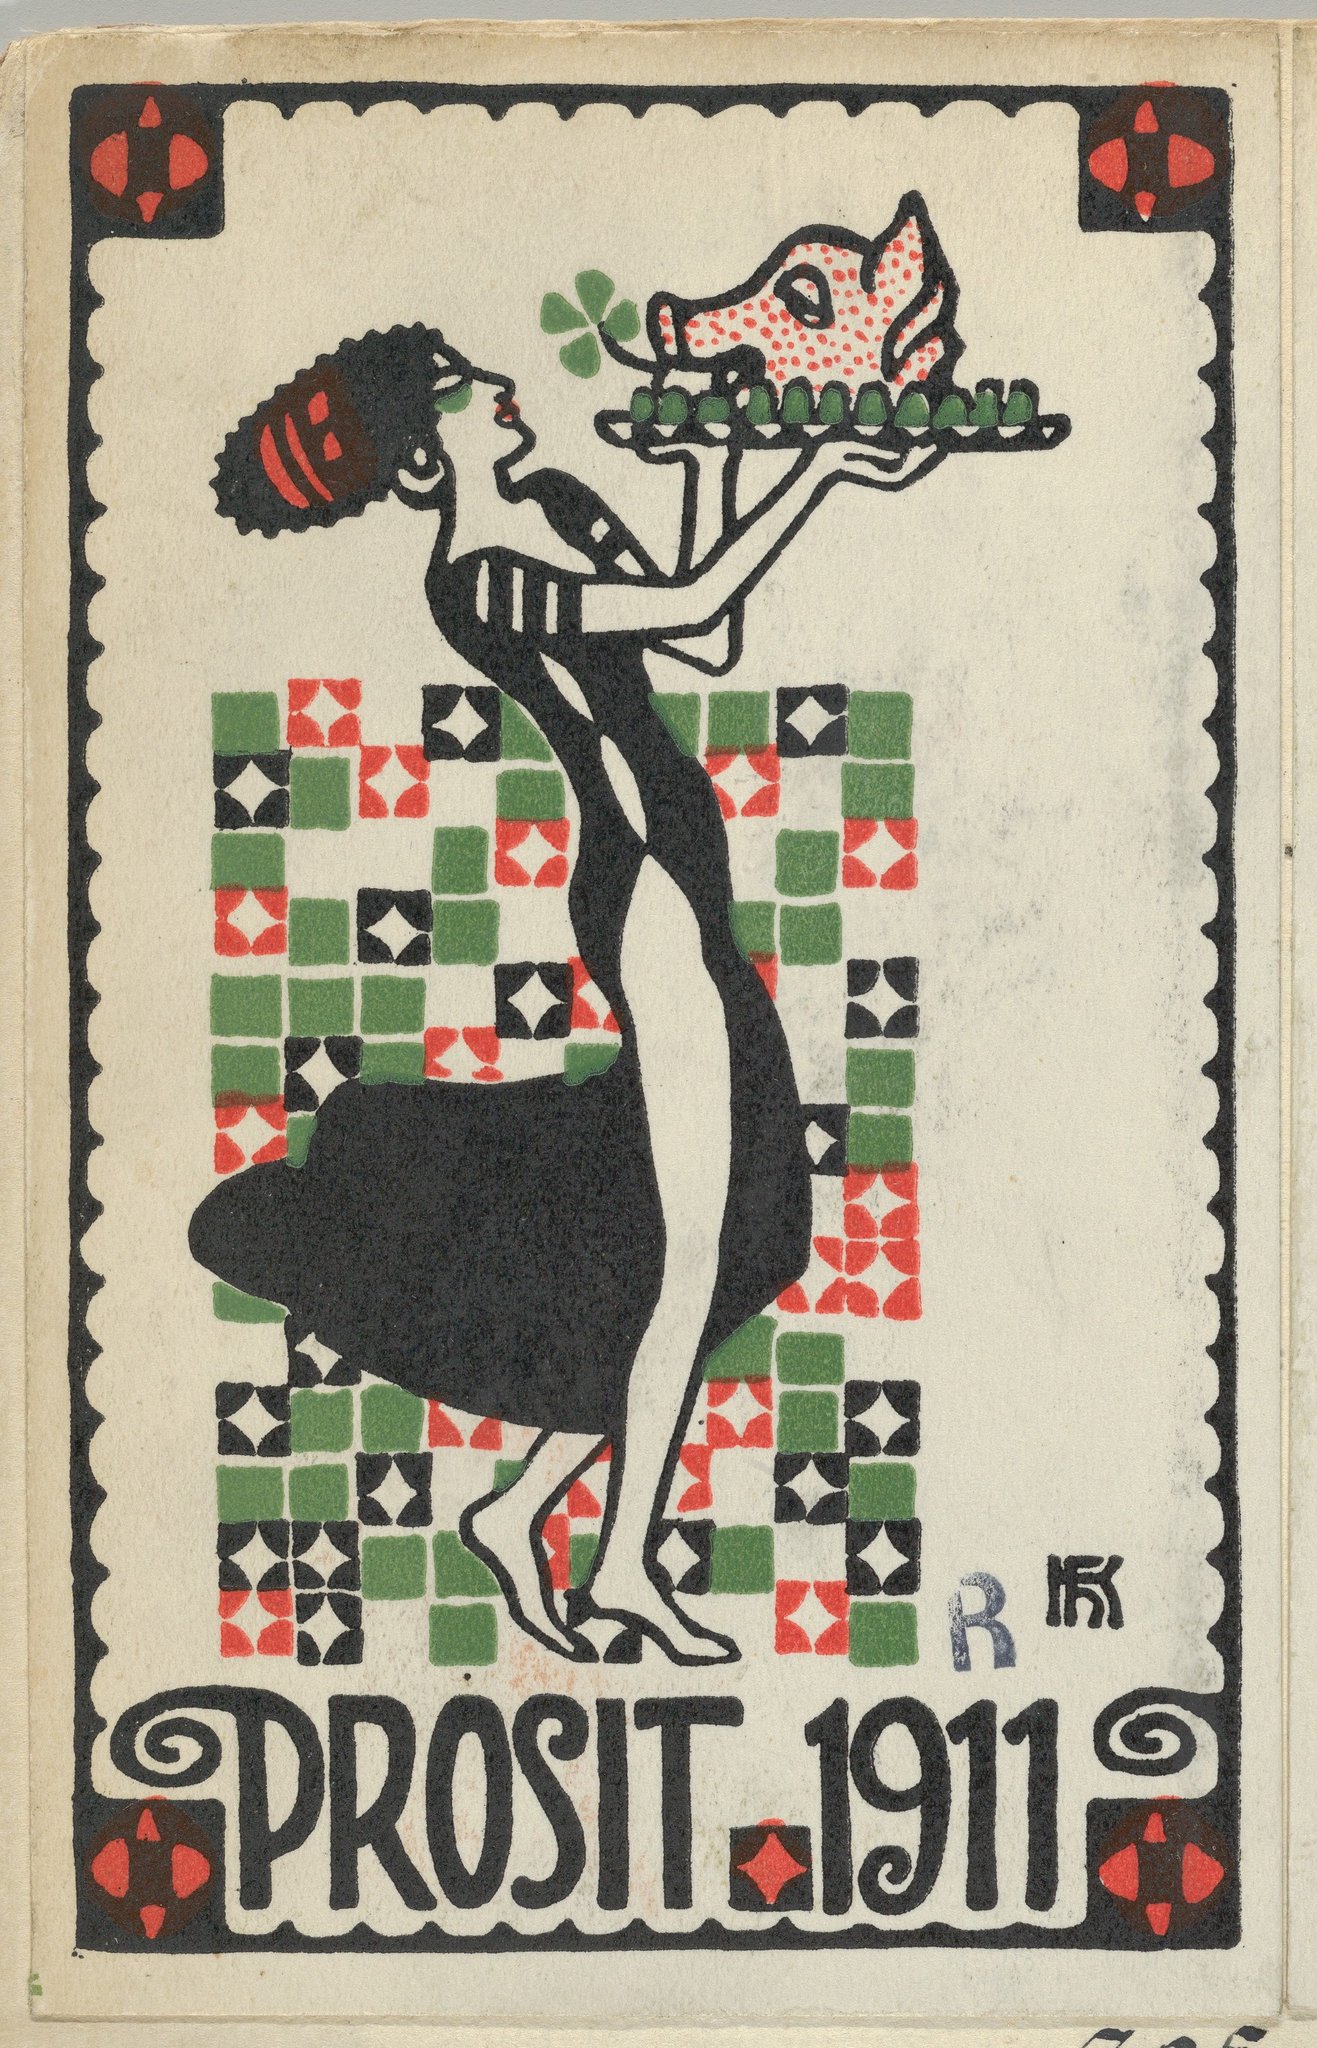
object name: print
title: New Years Card: Cheers 1911 (Prosit)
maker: hans kalmsteiner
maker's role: artist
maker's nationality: austrian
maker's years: 1882-1914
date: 1910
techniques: lithograph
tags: women